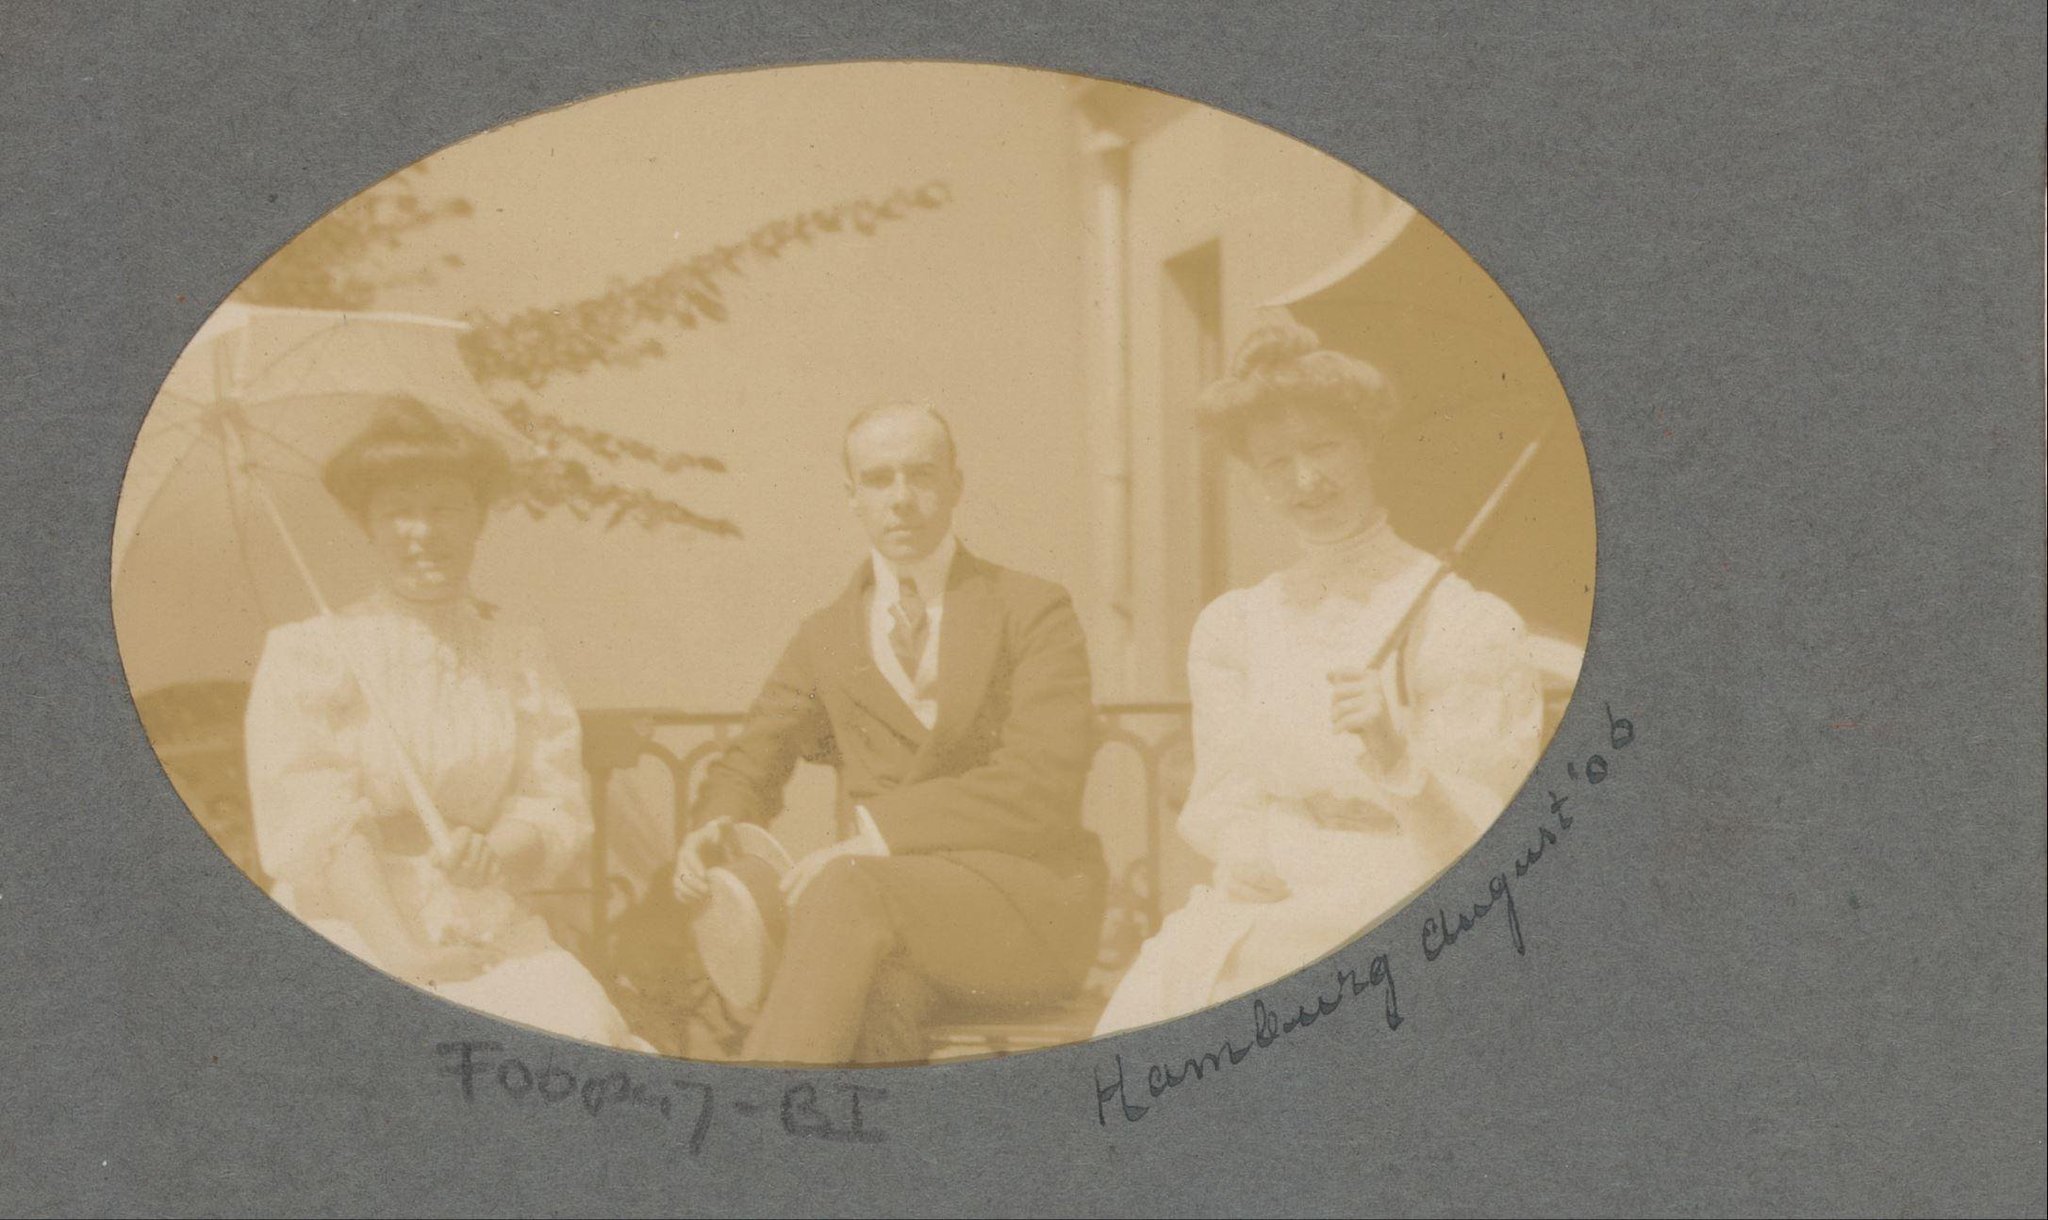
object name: album leaf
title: Groepsportret van twee vrouwen en een man in Hamburg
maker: Anonymous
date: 1906-1908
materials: cardboard, paper, photographic support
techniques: gelatin silver print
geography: hamburg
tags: adult woman, adult man, parasol, sunshade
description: Onderdeel van Reisalbum van een Nederlandse familie met bezienswaardigheden in Europa, Egypte en New York.